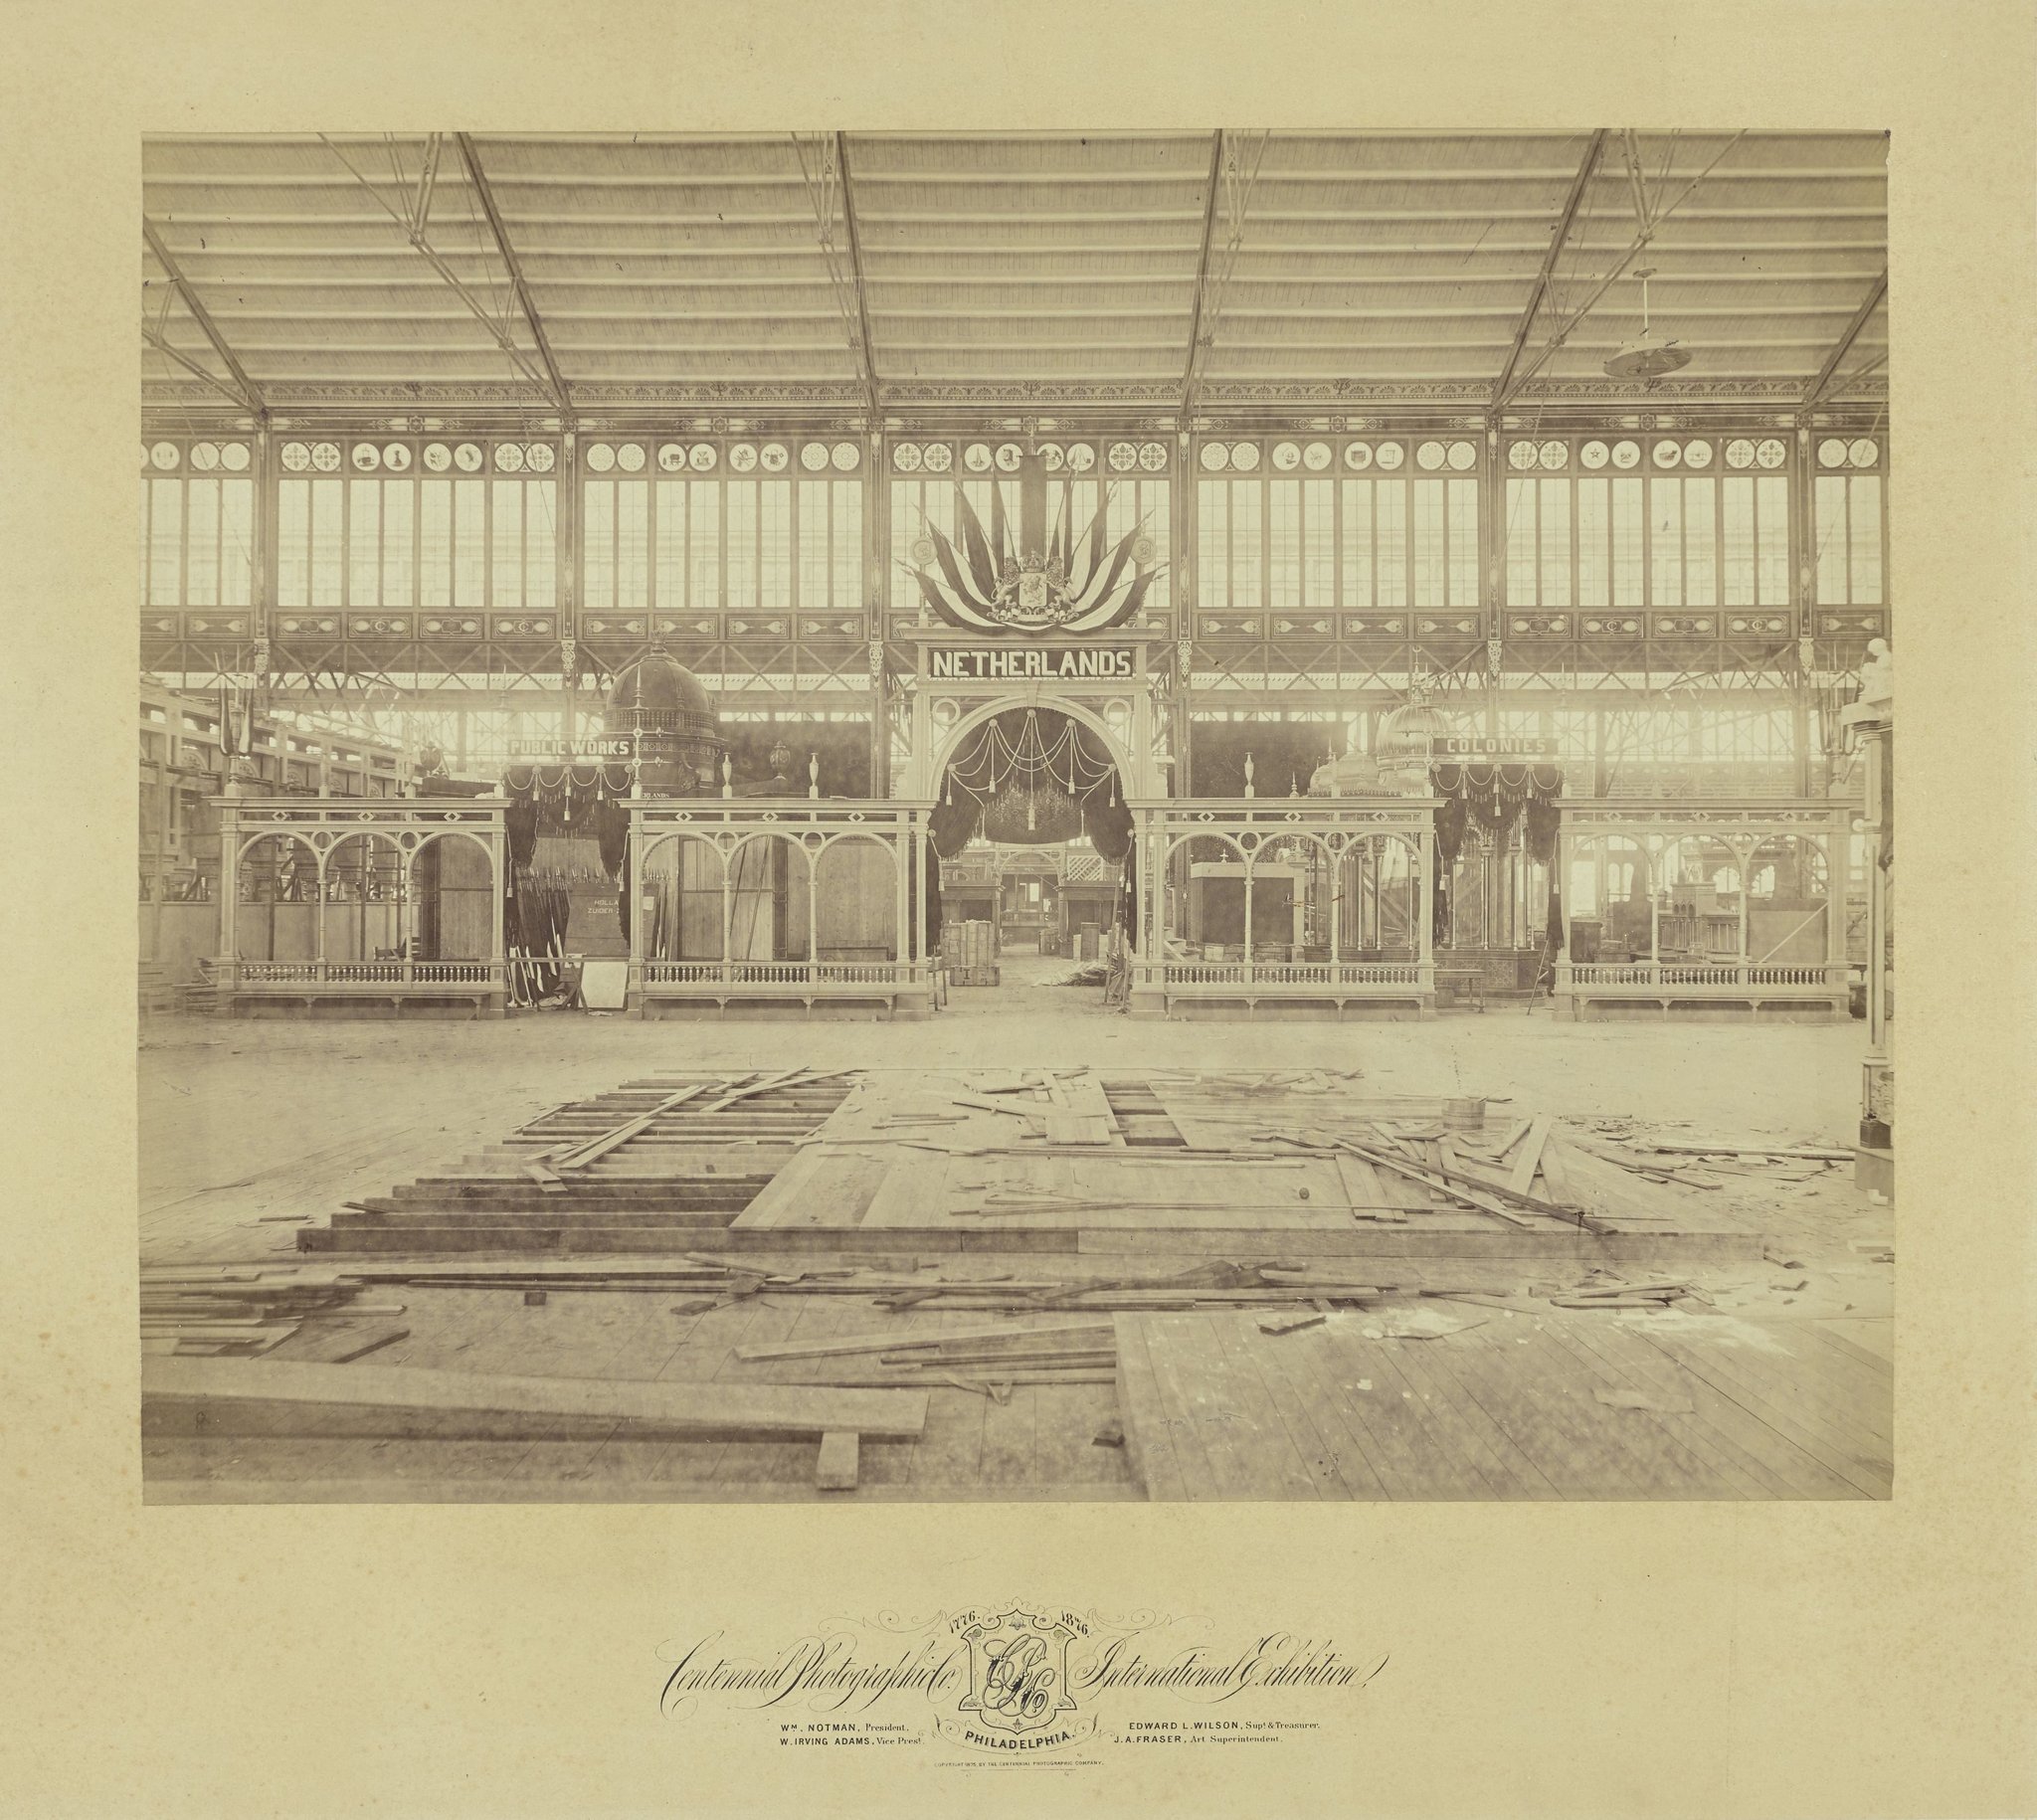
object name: photograph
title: International Exhibition Philadelphia 1876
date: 1876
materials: cardboard, paper, photographic support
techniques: albumen print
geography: philadelphia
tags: trade exhibition, industries fair, collection, exhibition, show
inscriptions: collector's mark: Lugt 2166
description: Opbouw van de Nederlandse afdeling in de tentoonstellingszaal van de International Exhibition te Philadelphia in de Verenigde Staten, 1876.